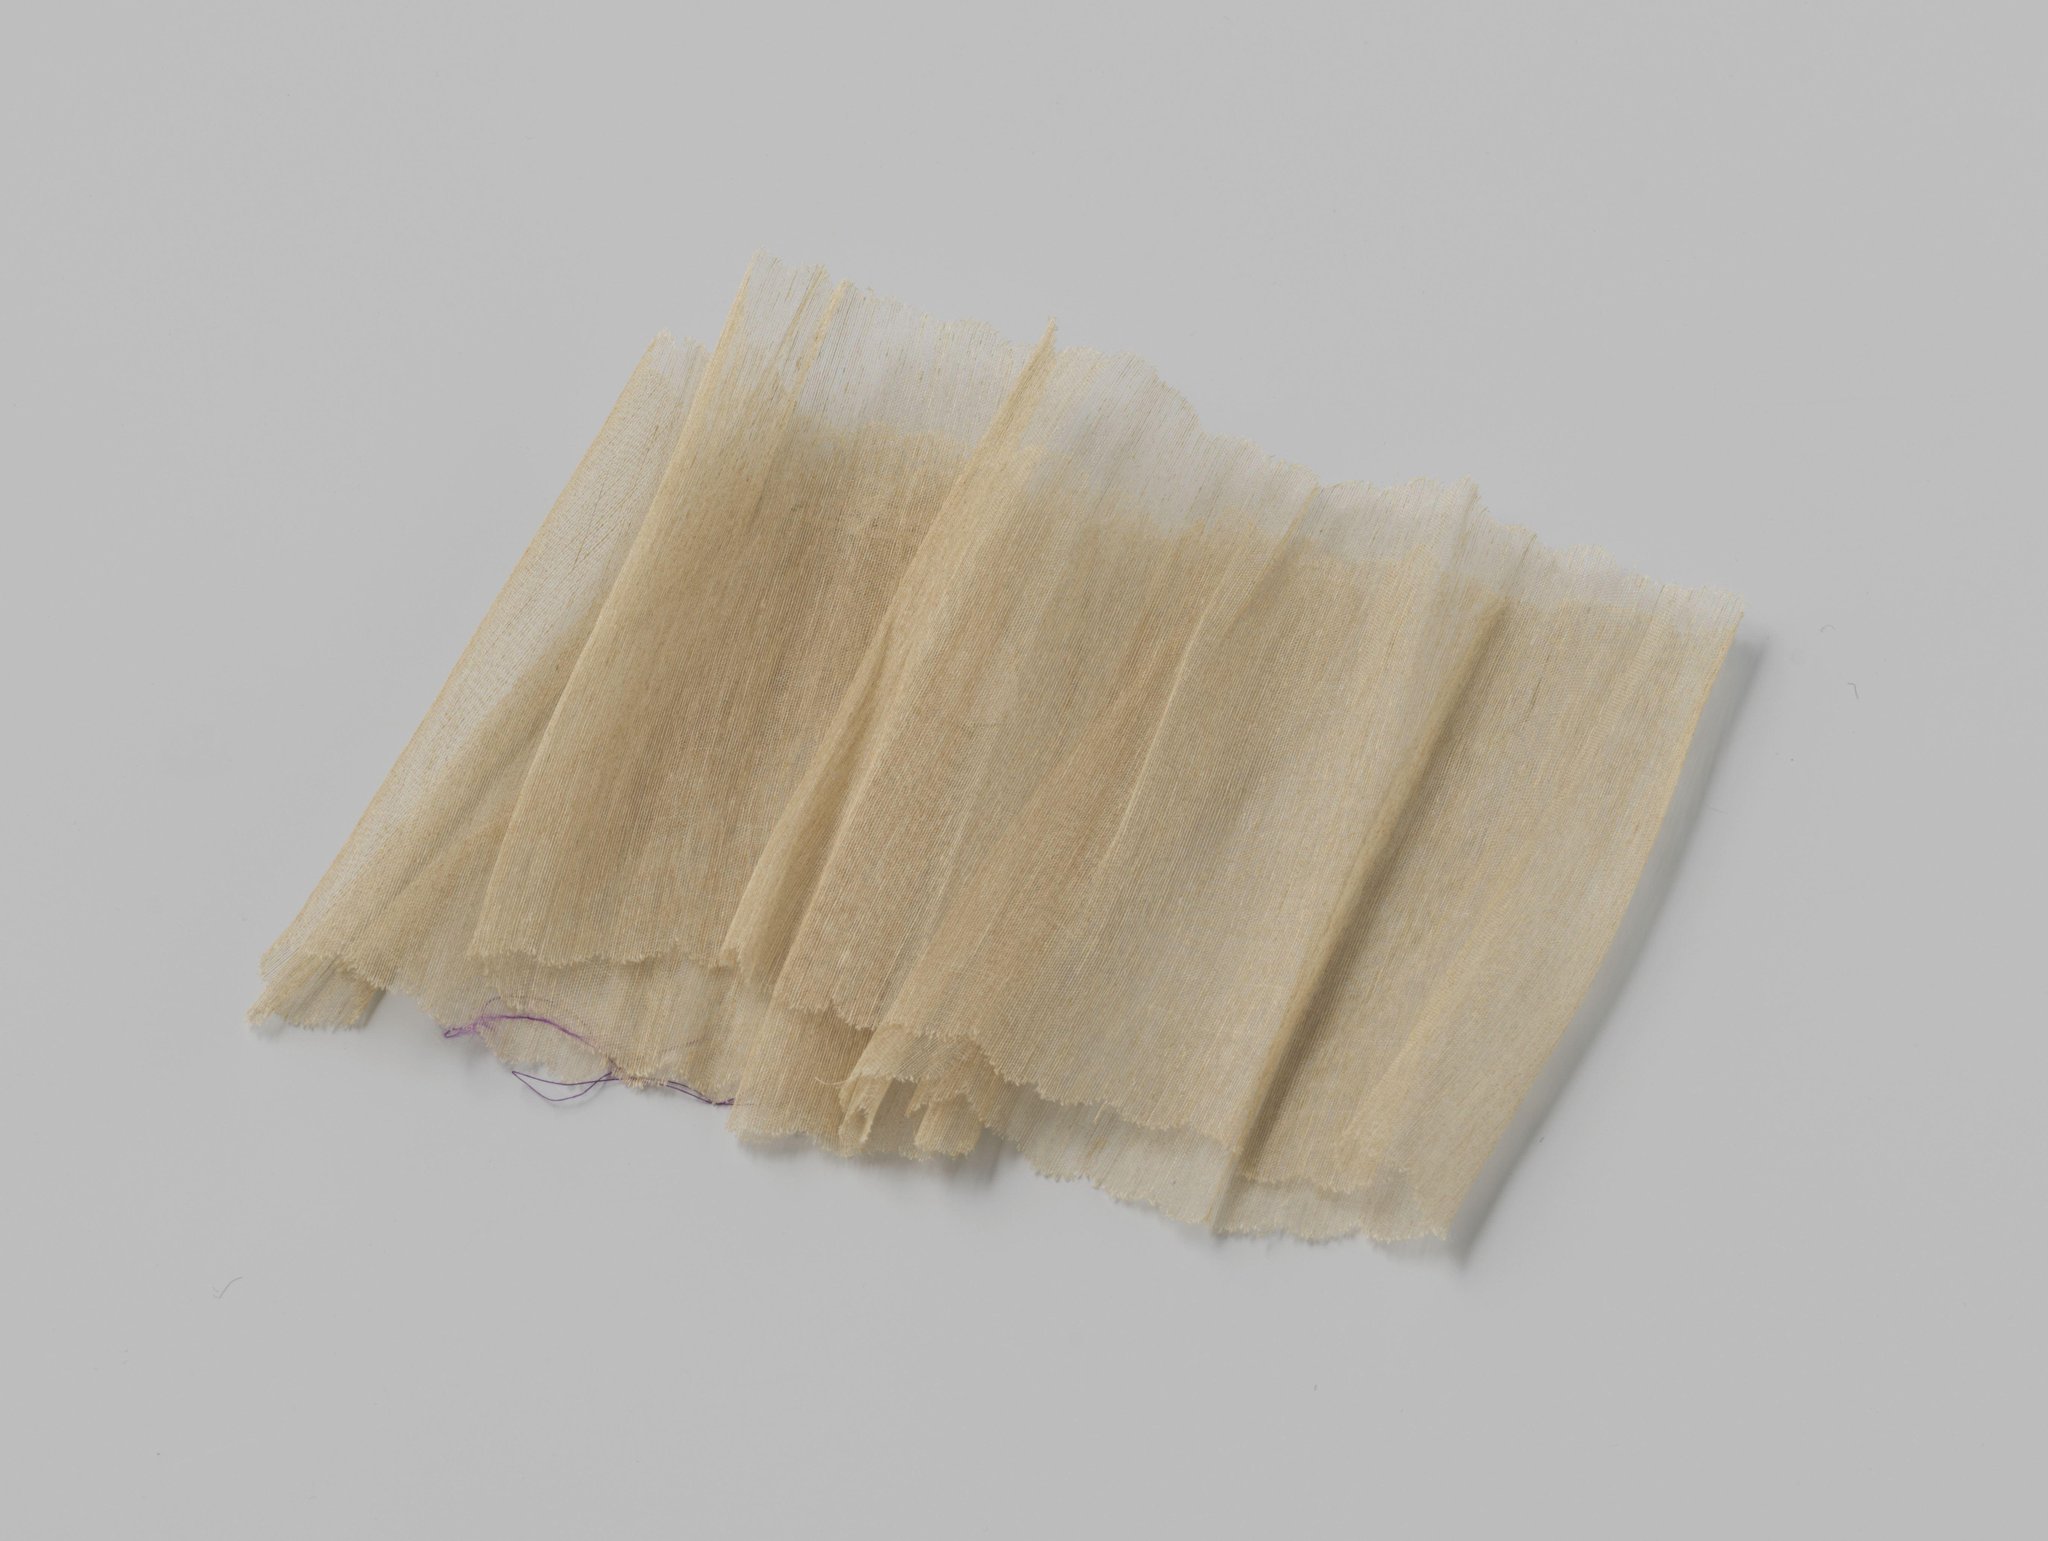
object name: parasolgaas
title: Strook parasolgaas, écru, in schulpen geknipt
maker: gustav schnitzler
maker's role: paraplufabrikant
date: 1910-1940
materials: cotton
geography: nijmegen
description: Metrage parasolkatoen, stukgoed. Halfzijden crêpe in effen beige. Firma etiket van T. & F. Een geschulpt gesneden strook van hetzelfde.